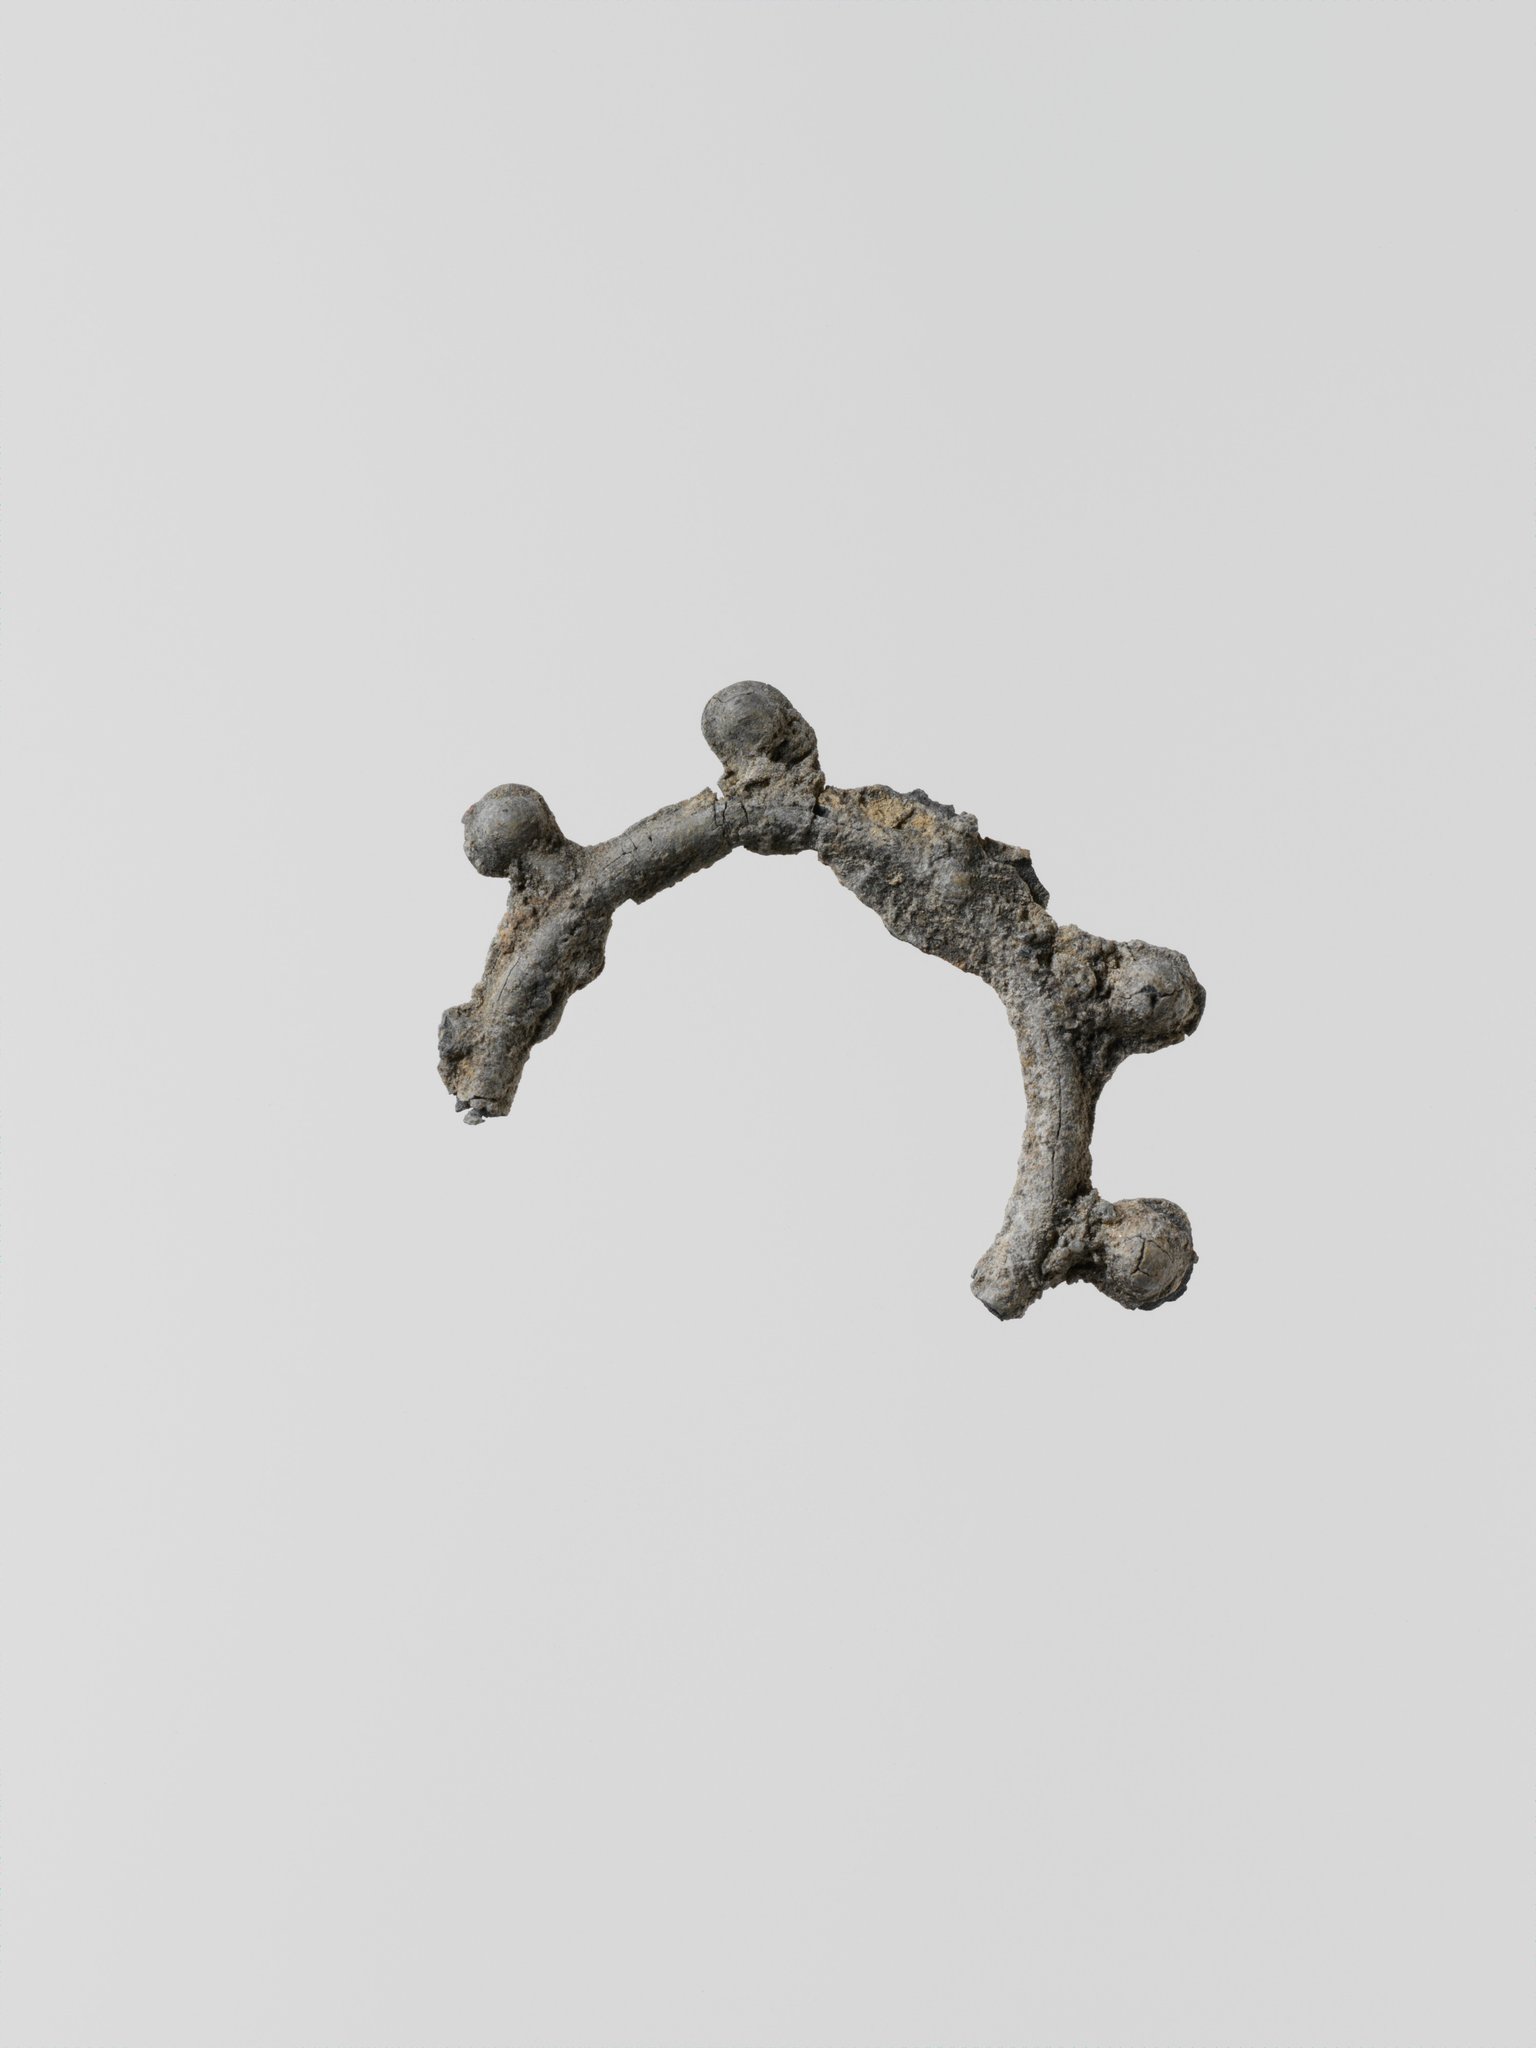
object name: wreath, 6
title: Wreaths, 6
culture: greek, laconian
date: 7000-30 BCE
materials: lead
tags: wreaths